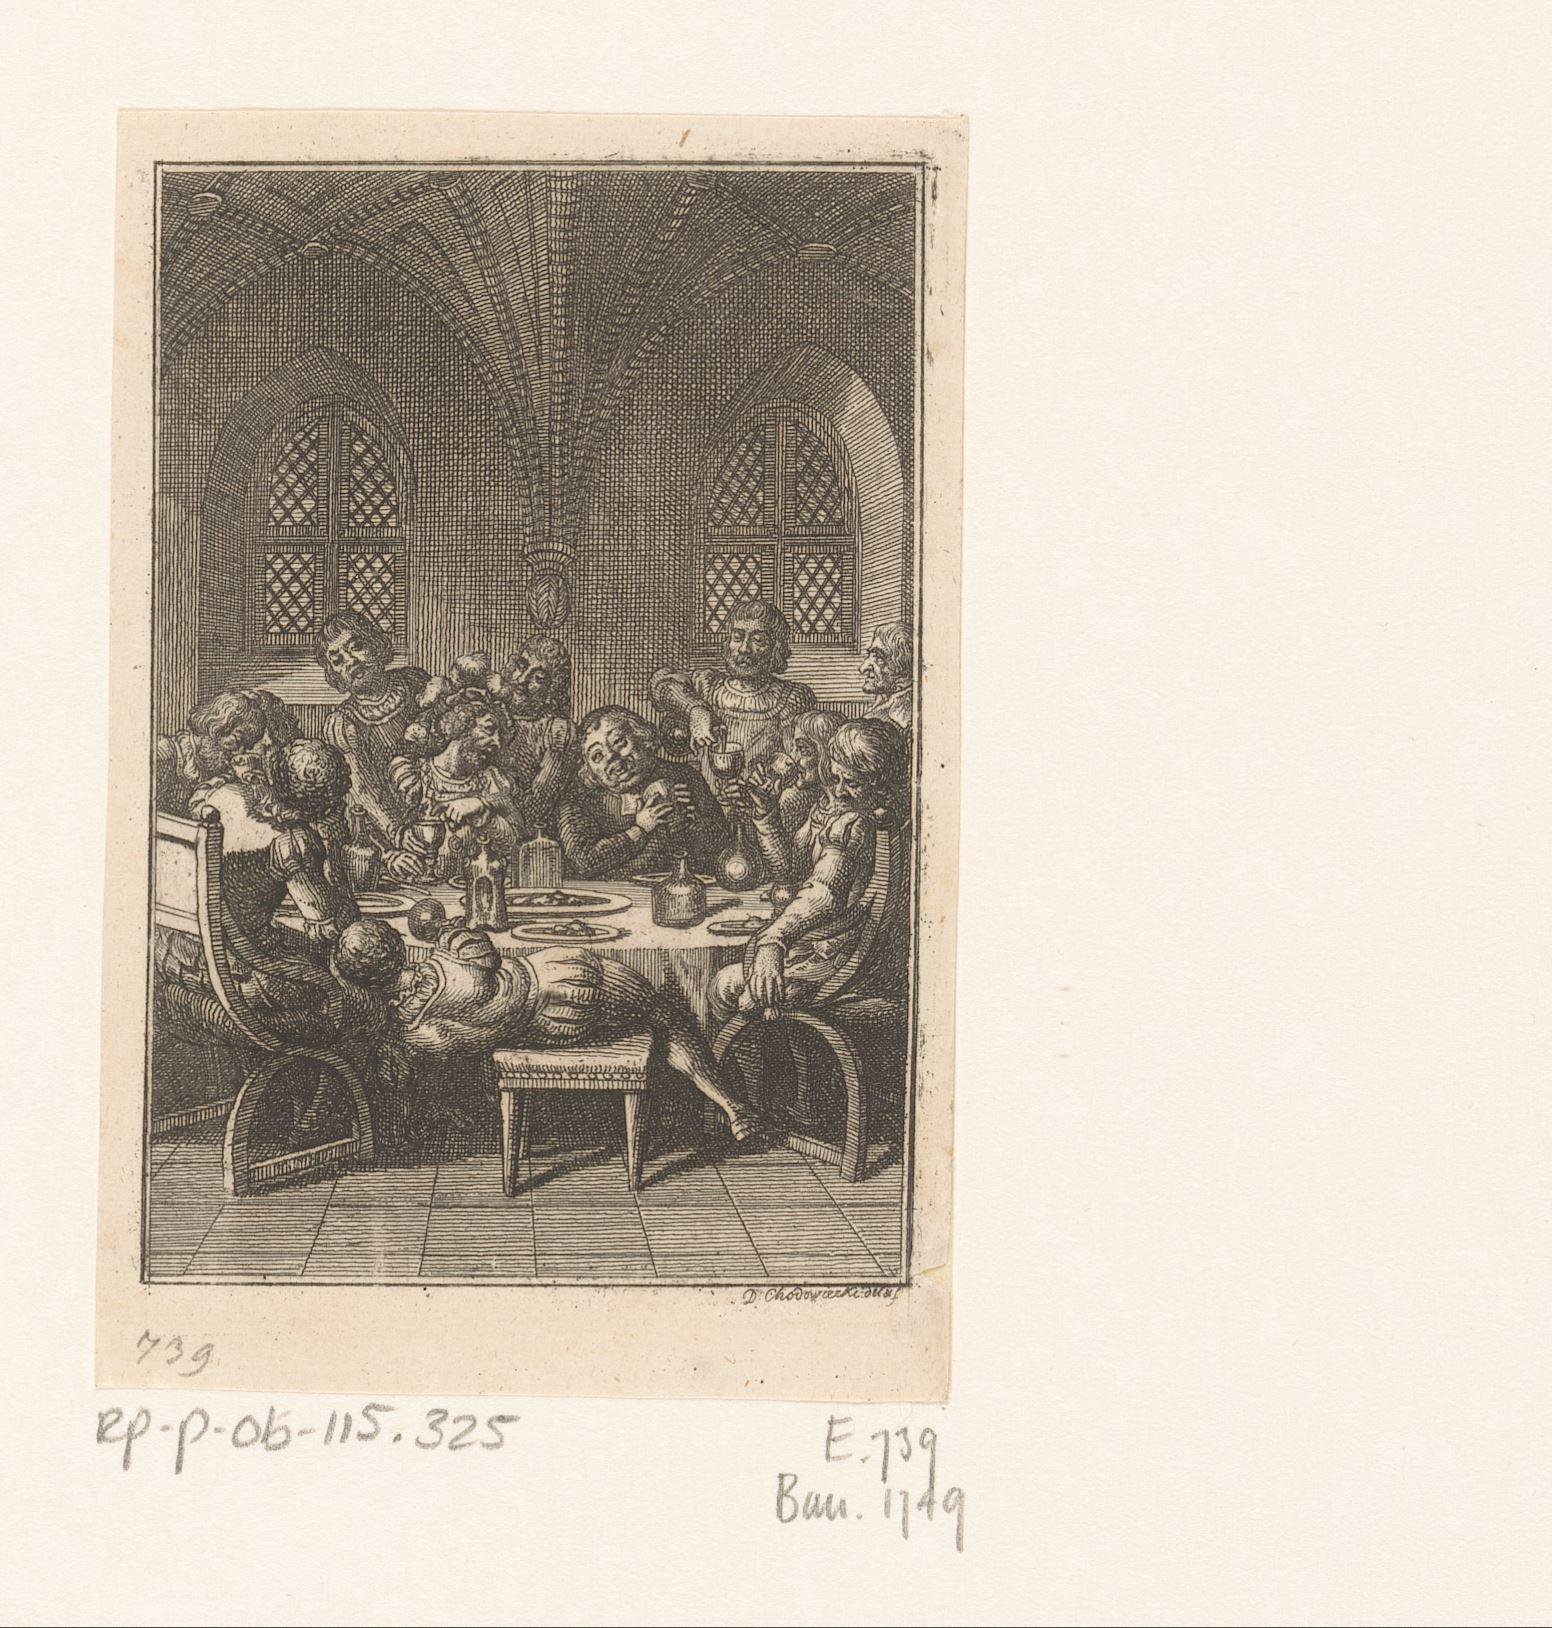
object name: print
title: Dronken heren aan tafel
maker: daniel nikolaus chodowiecki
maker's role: draughtsman, print maker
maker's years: 1726-1801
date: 1794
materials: paper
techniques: etching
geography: berlin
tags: drunkenness, celebration meal, feast, banquet, vault ~ architecture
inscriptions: collector's mark: Lugt 2228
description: Prent gebruikt voor: Becker, Wilhelm Gottlieb. Taschenbuch und Almanach zum geselligen Vergnügen (...). Leipzig: Voss und Companie, 1795.